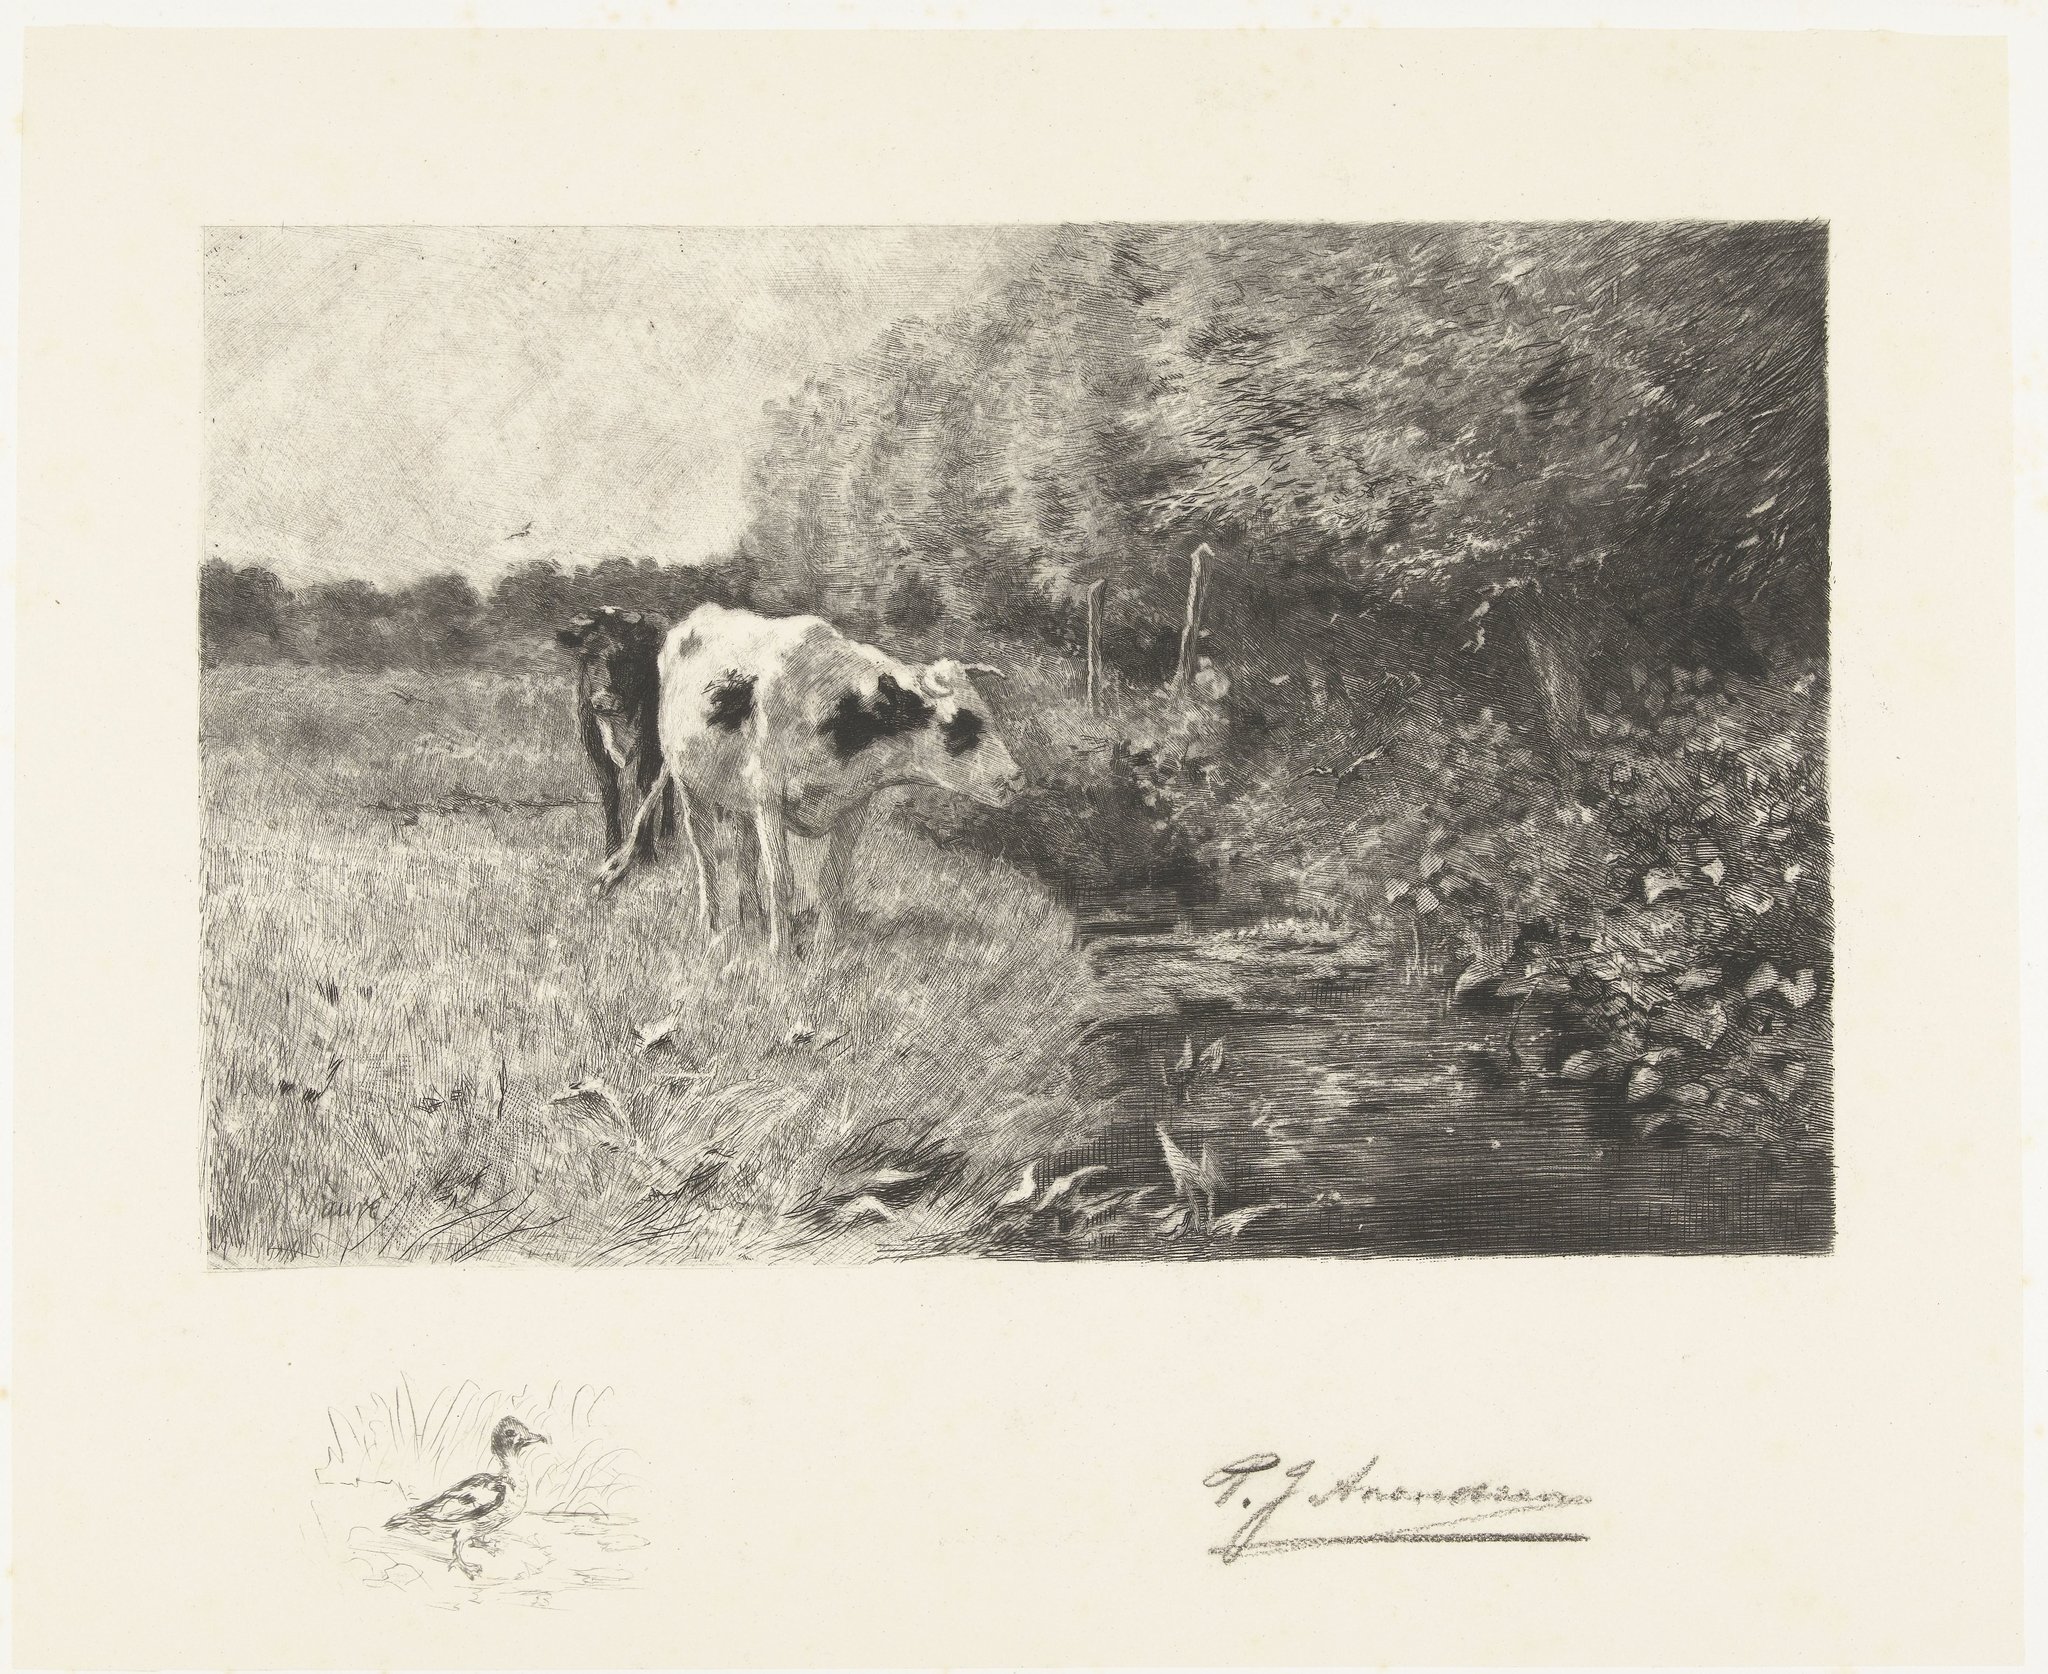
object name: print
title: Twee koeien in de wei bij een sloot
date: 1856-1900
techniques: printmaking, etching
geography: netherlands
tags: landscapes in the temperate zone, bovine cattle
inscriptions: collector's mark: Lugt 2228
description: Twee koeien in de wei bij een sloot. In de marge een eend.